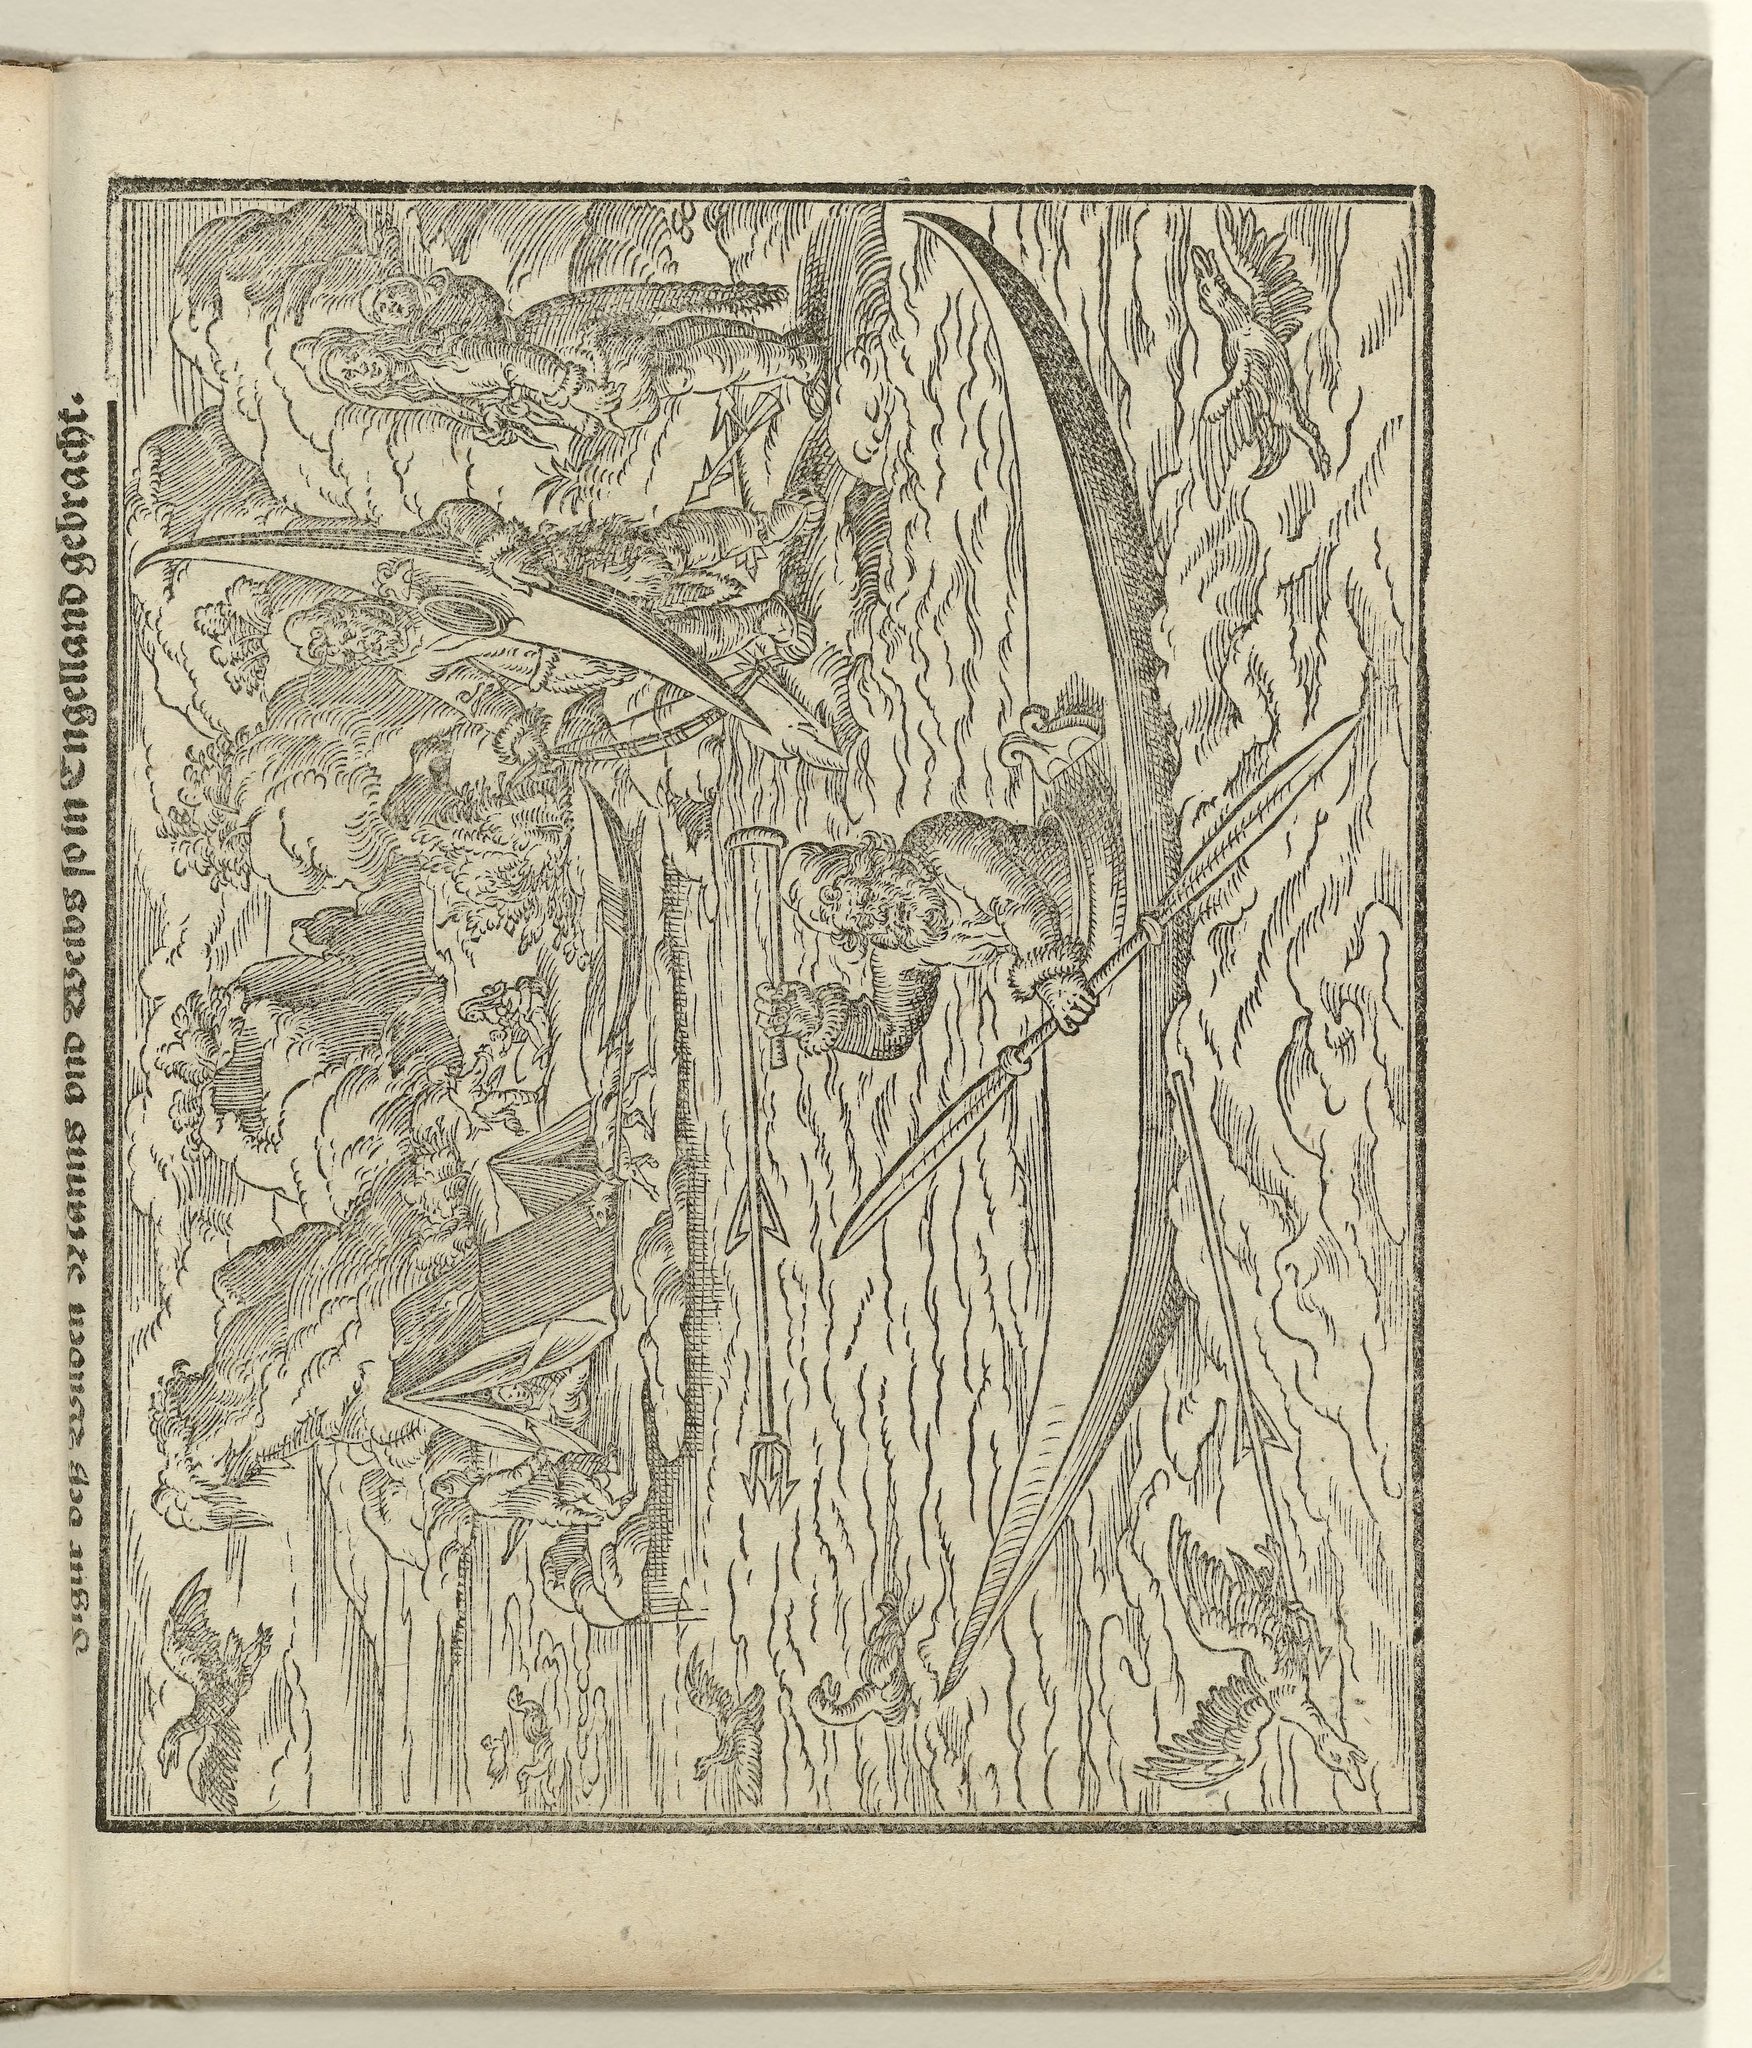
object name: print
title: Figur des Wilden Manns und Weibs so in Engelland gebracht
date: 1598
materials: paper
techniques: engraving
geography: nuremberg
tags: willem barendsz., jacob van heemskerck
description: Een bewoner van de poolstreken peddelt in een kajak en gooit harpoenen naar vogels op het water. Op de achtergrond een rotsachtig landschap met een vrouw met kind, een man die een kajak draagt, enkele tenten met mensen en een sledehond. De titel van de prent verwijst naar de man, vrouw en kind uit het noordoosten van Canada die de Engelse ontdekkingsreiziger Martin Frobisher in 1577 ontvoerde en mee naar Engeland nam. In: 'Warhafftige Relation. Der dreyen newen unerhörten seltzamen Schiffart so die Holländischen und Seeländischen Schiff....Anno 1594, 1595 und 1596 verricht' (1598).